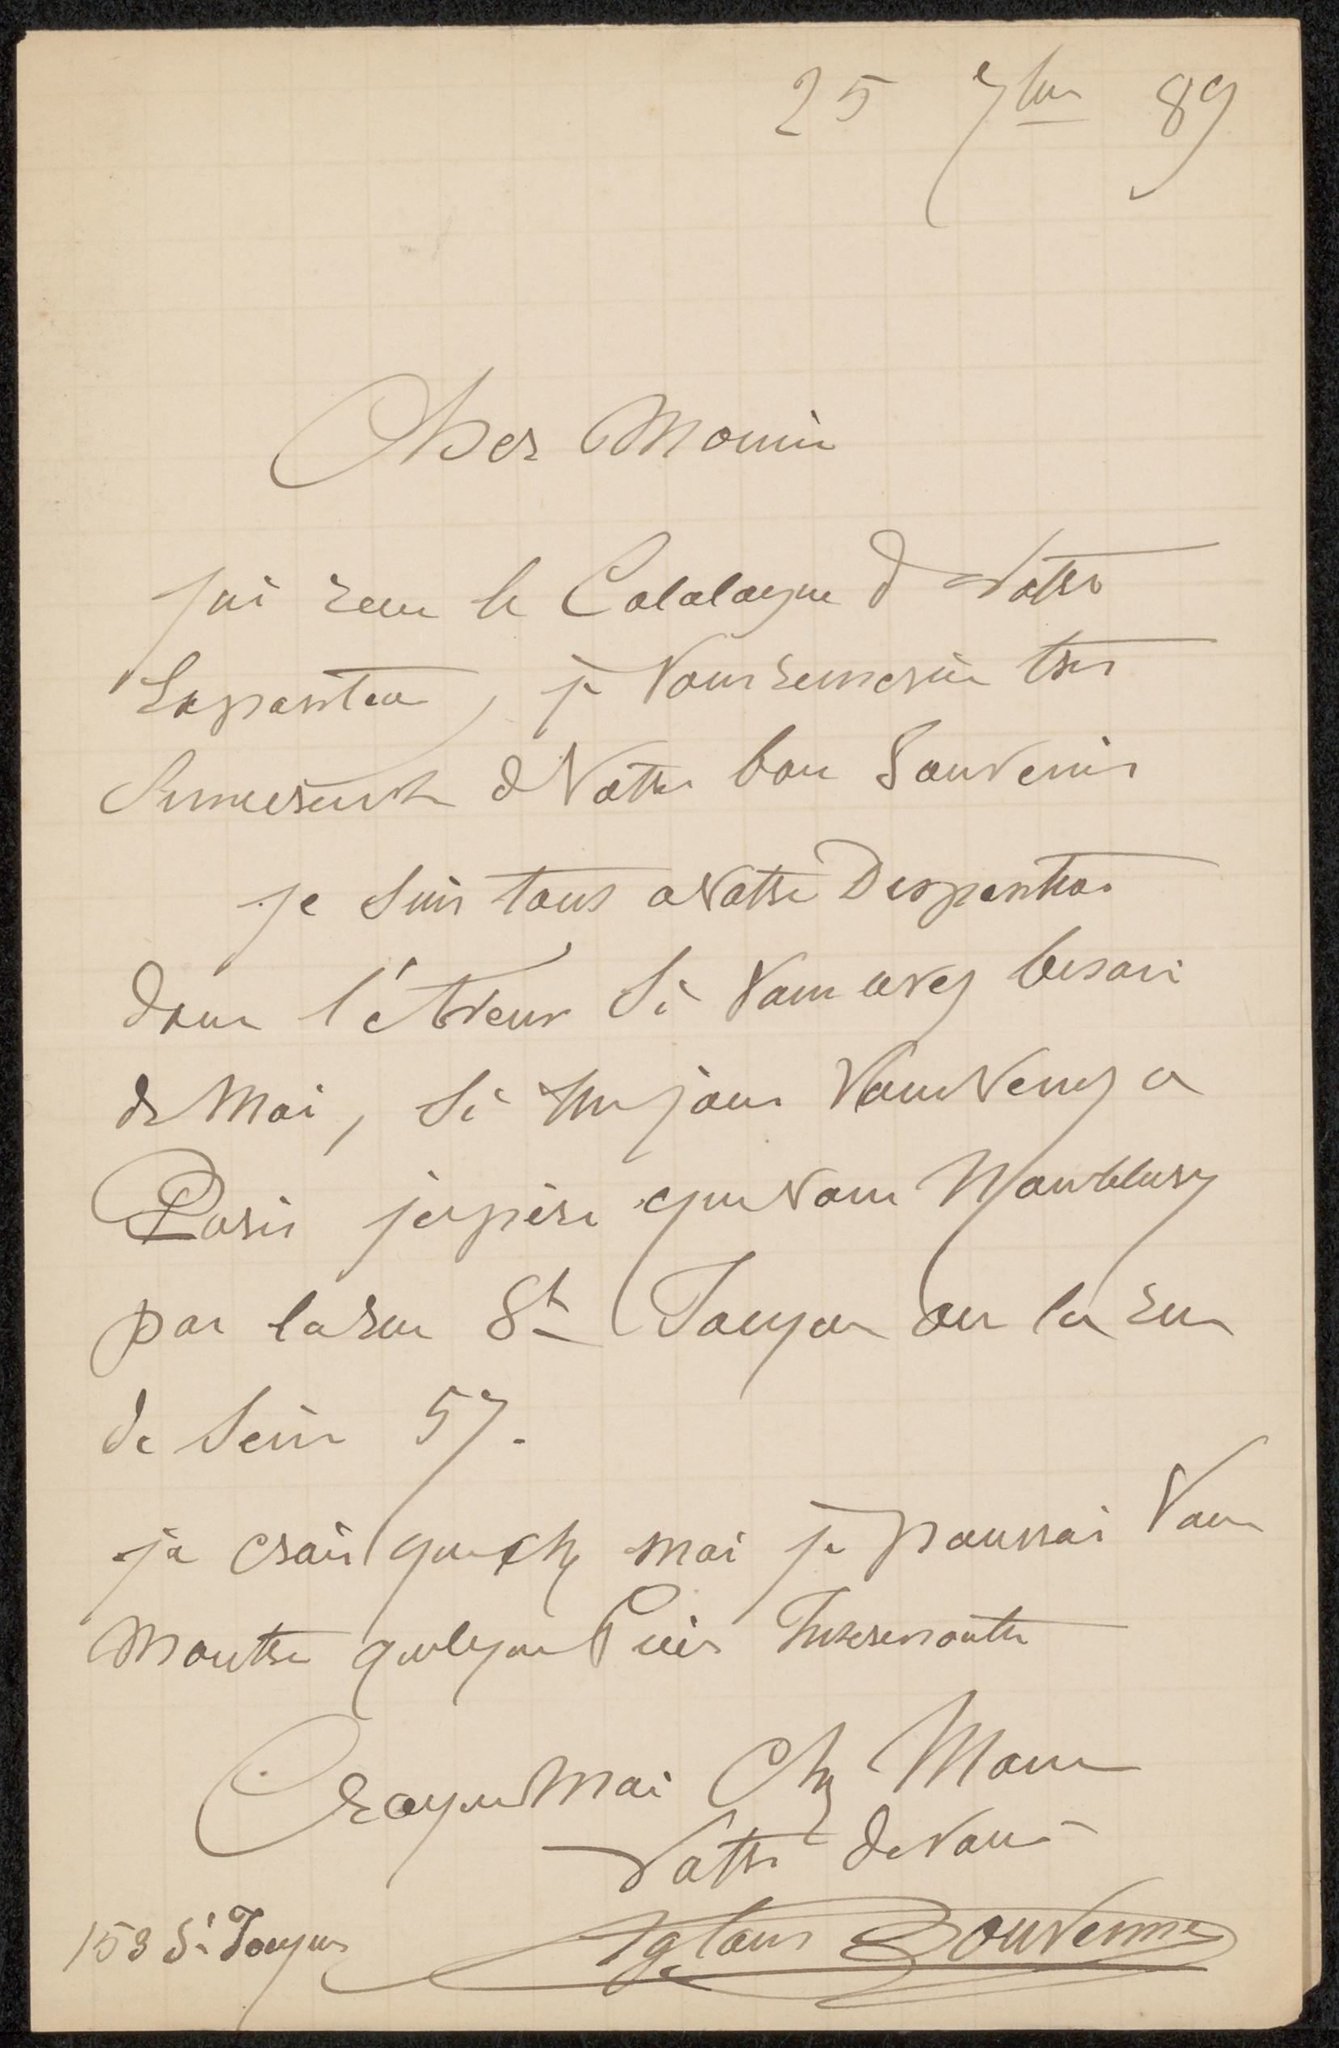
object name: letter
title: Brief aan Philip Zilcken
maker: aglaüs bouvenne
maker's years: 1829-1903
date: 1889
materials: ink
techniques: pen, writing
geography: paris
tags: the hague, painter, philip zilcken, temporary exhibition, 'salon', printed matter, paris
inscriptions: collector's mark: ‘RPK’